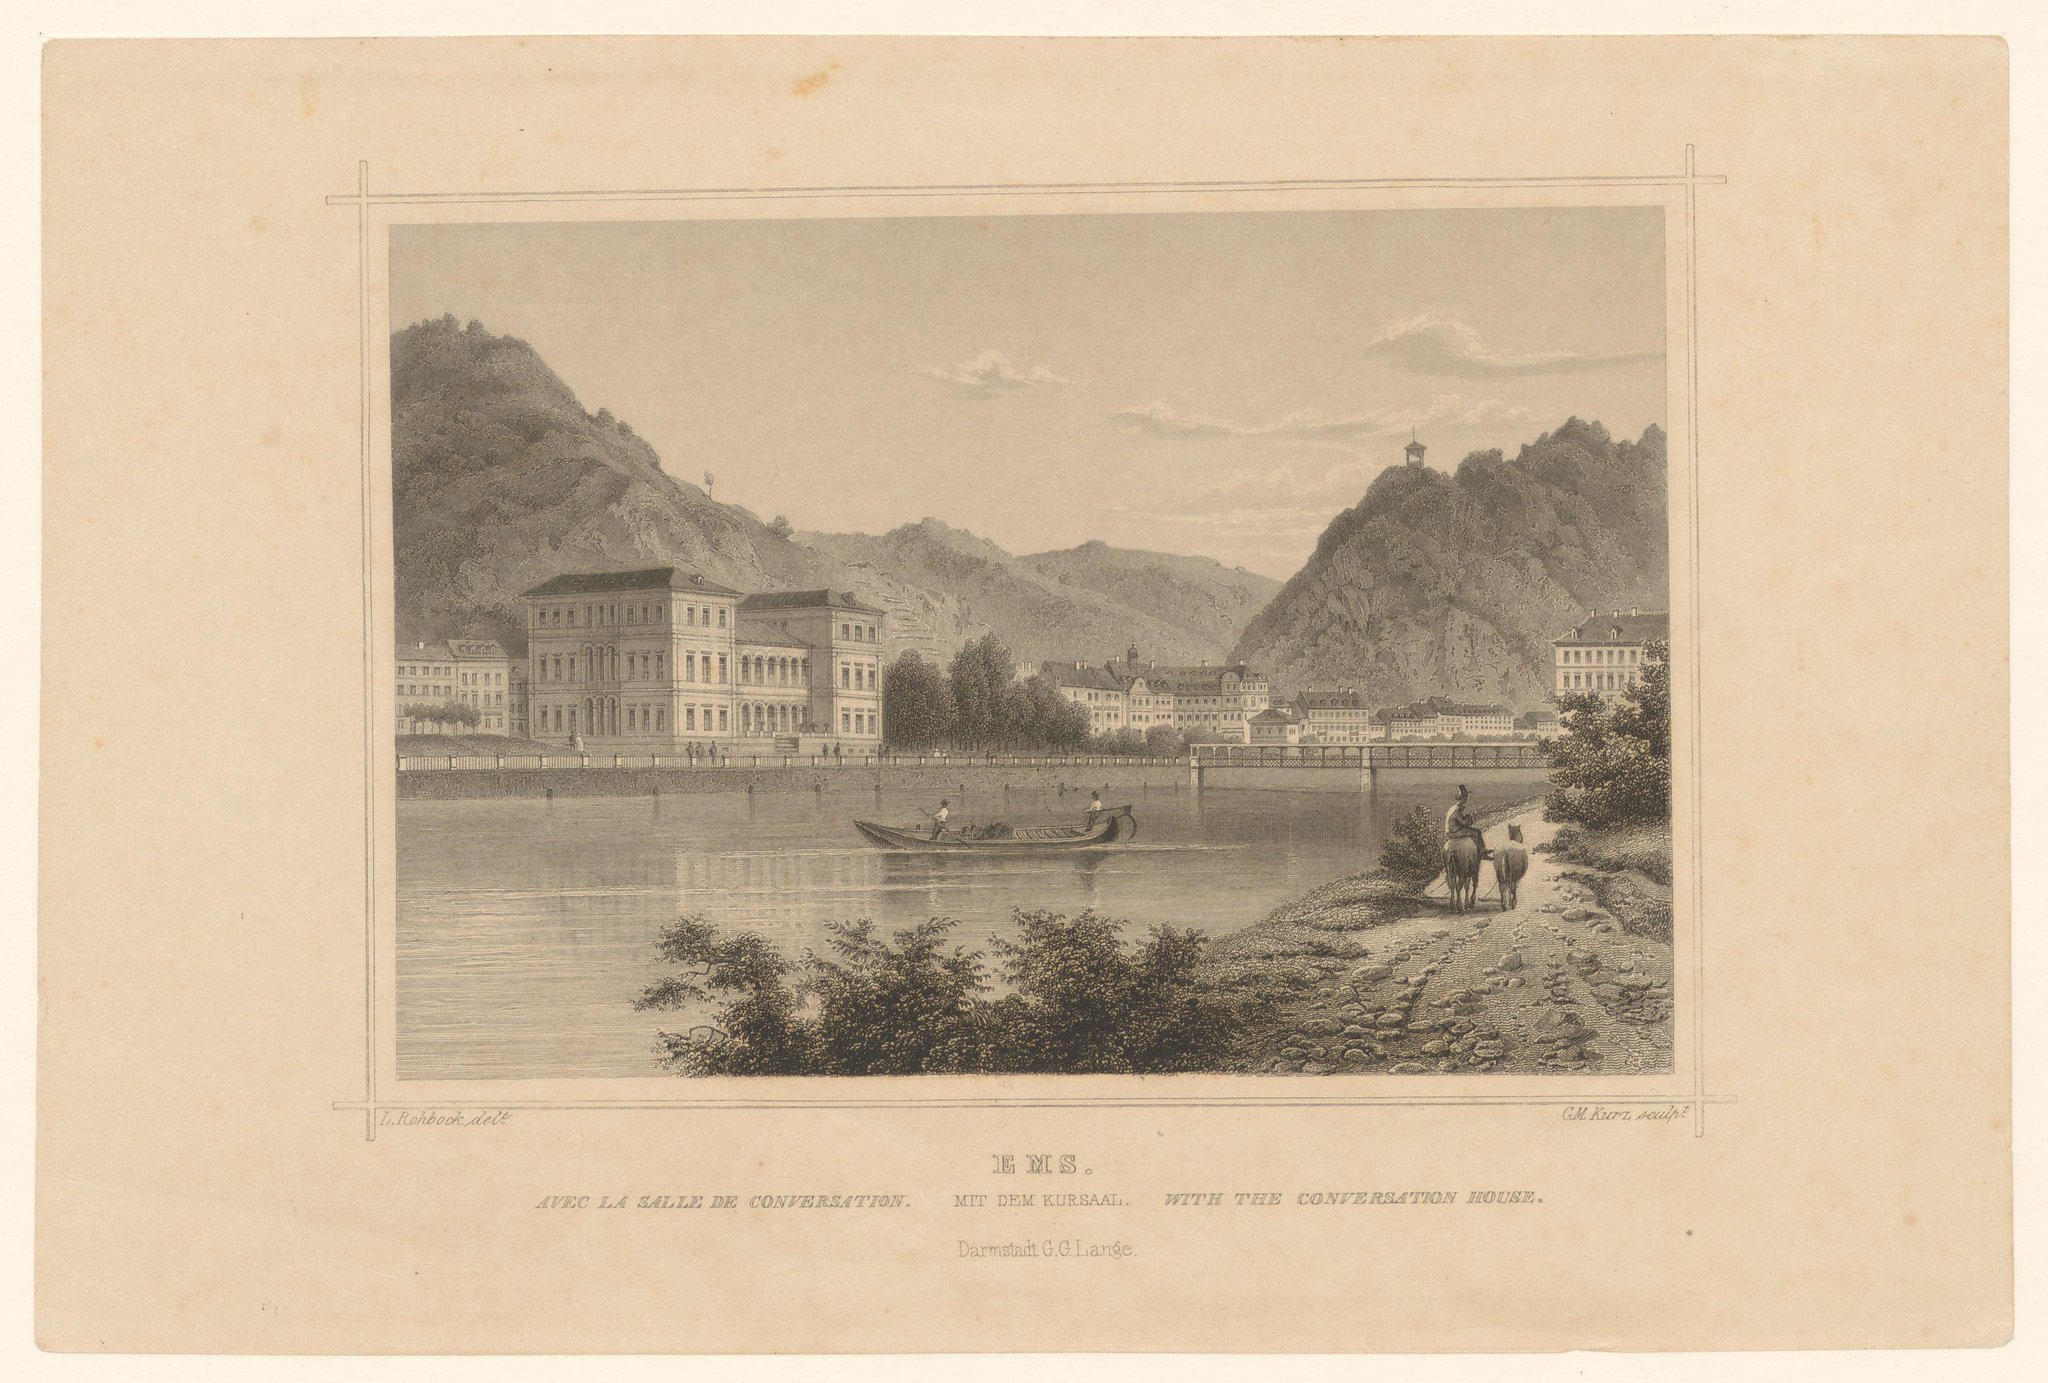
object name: print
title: Gezicht op Bad Ems en de Lahn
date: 1835-1883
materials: paper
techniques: engraving, etching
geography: darmstadt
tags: low hill country, river, city-view, and landscape with man-made constructions (+ city(-scape) with figures, staffage)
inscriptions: collector's mark: Lugt 2228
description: Tekst in het Frans, het Duits en het Engels in de ondermarge.